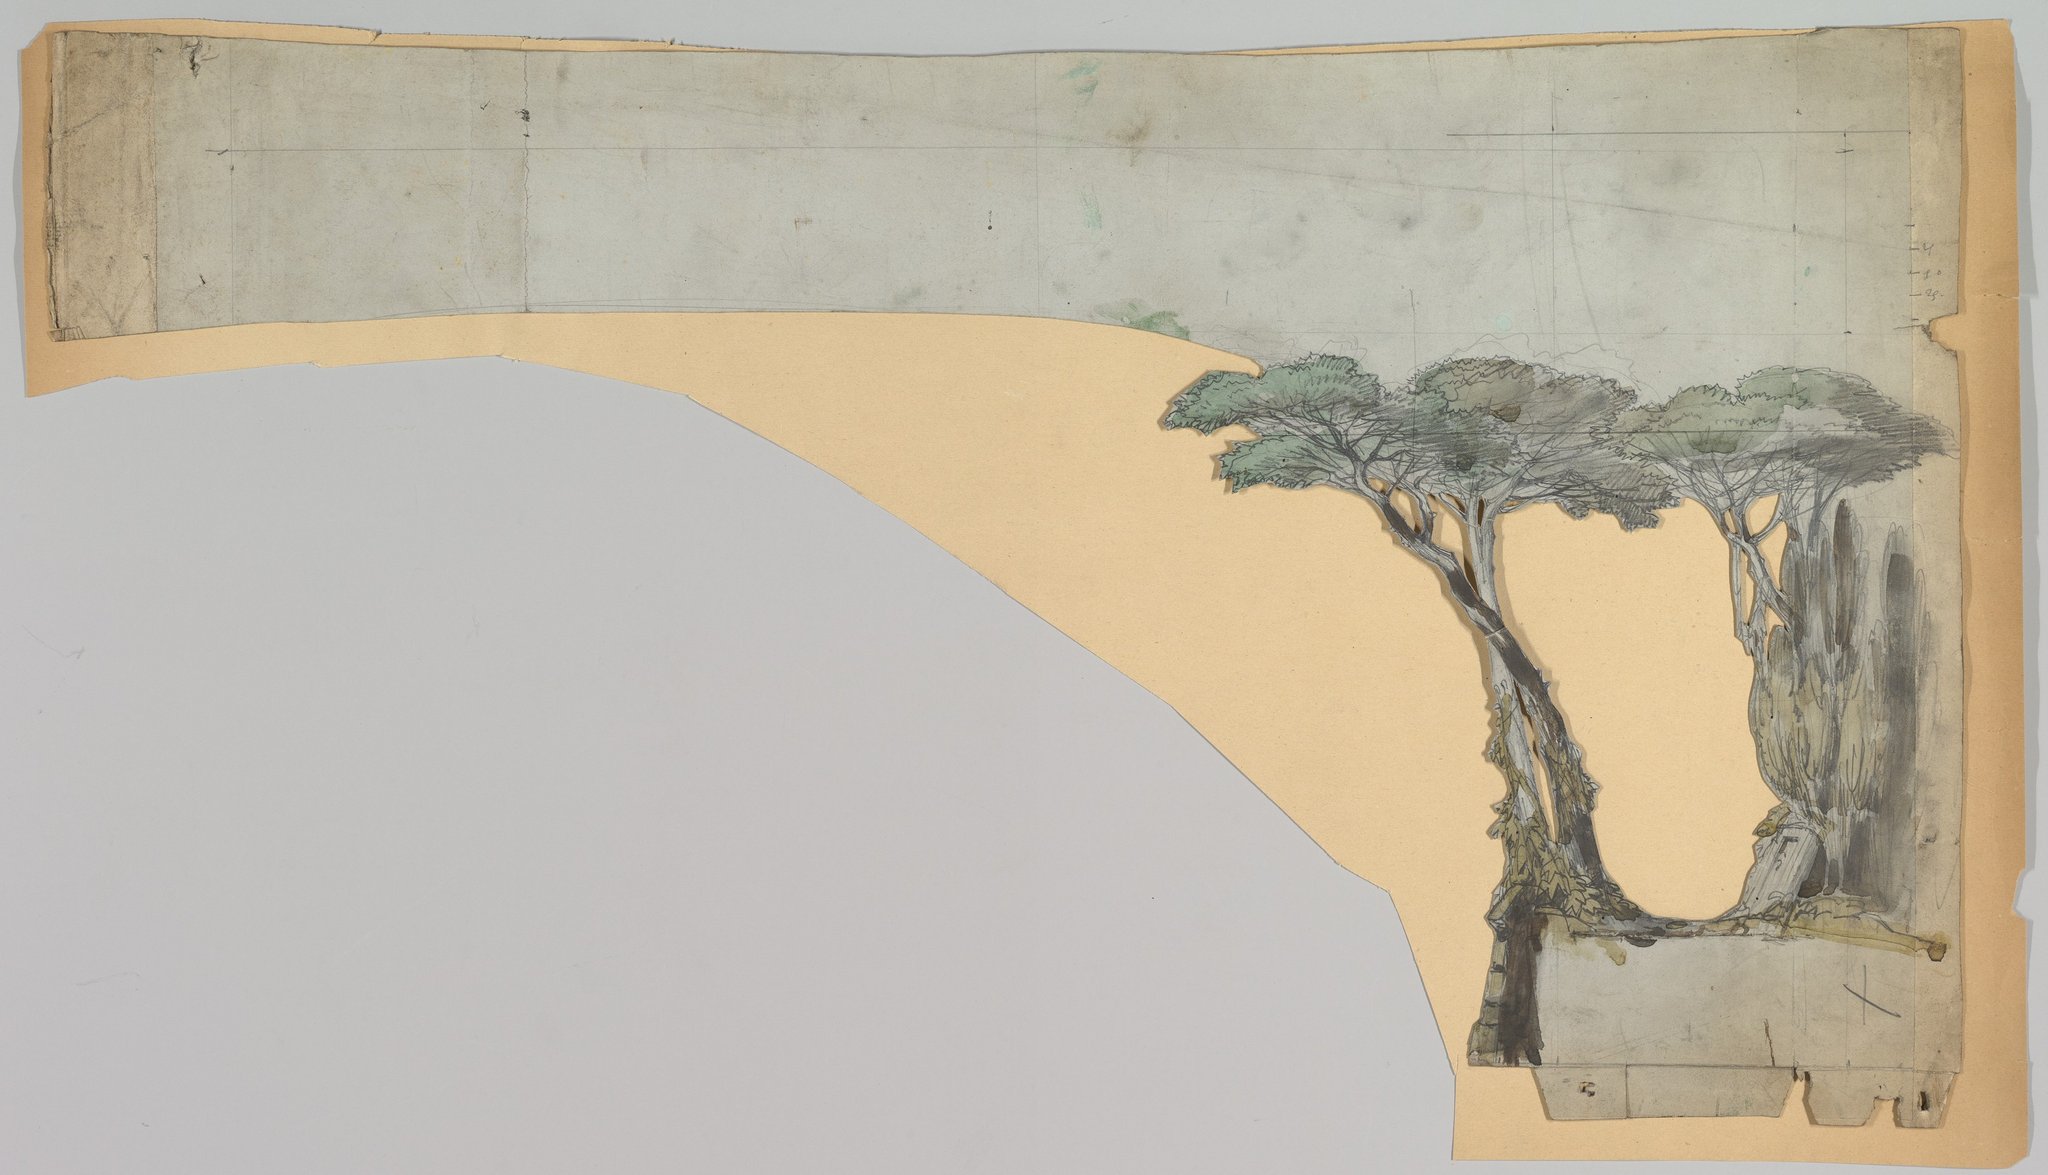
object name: drawing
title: Design for a Stage Set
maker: eugène cicéri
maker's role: artist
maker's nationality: french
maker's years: 1813-1890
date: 1830-1890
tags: trees,stage design